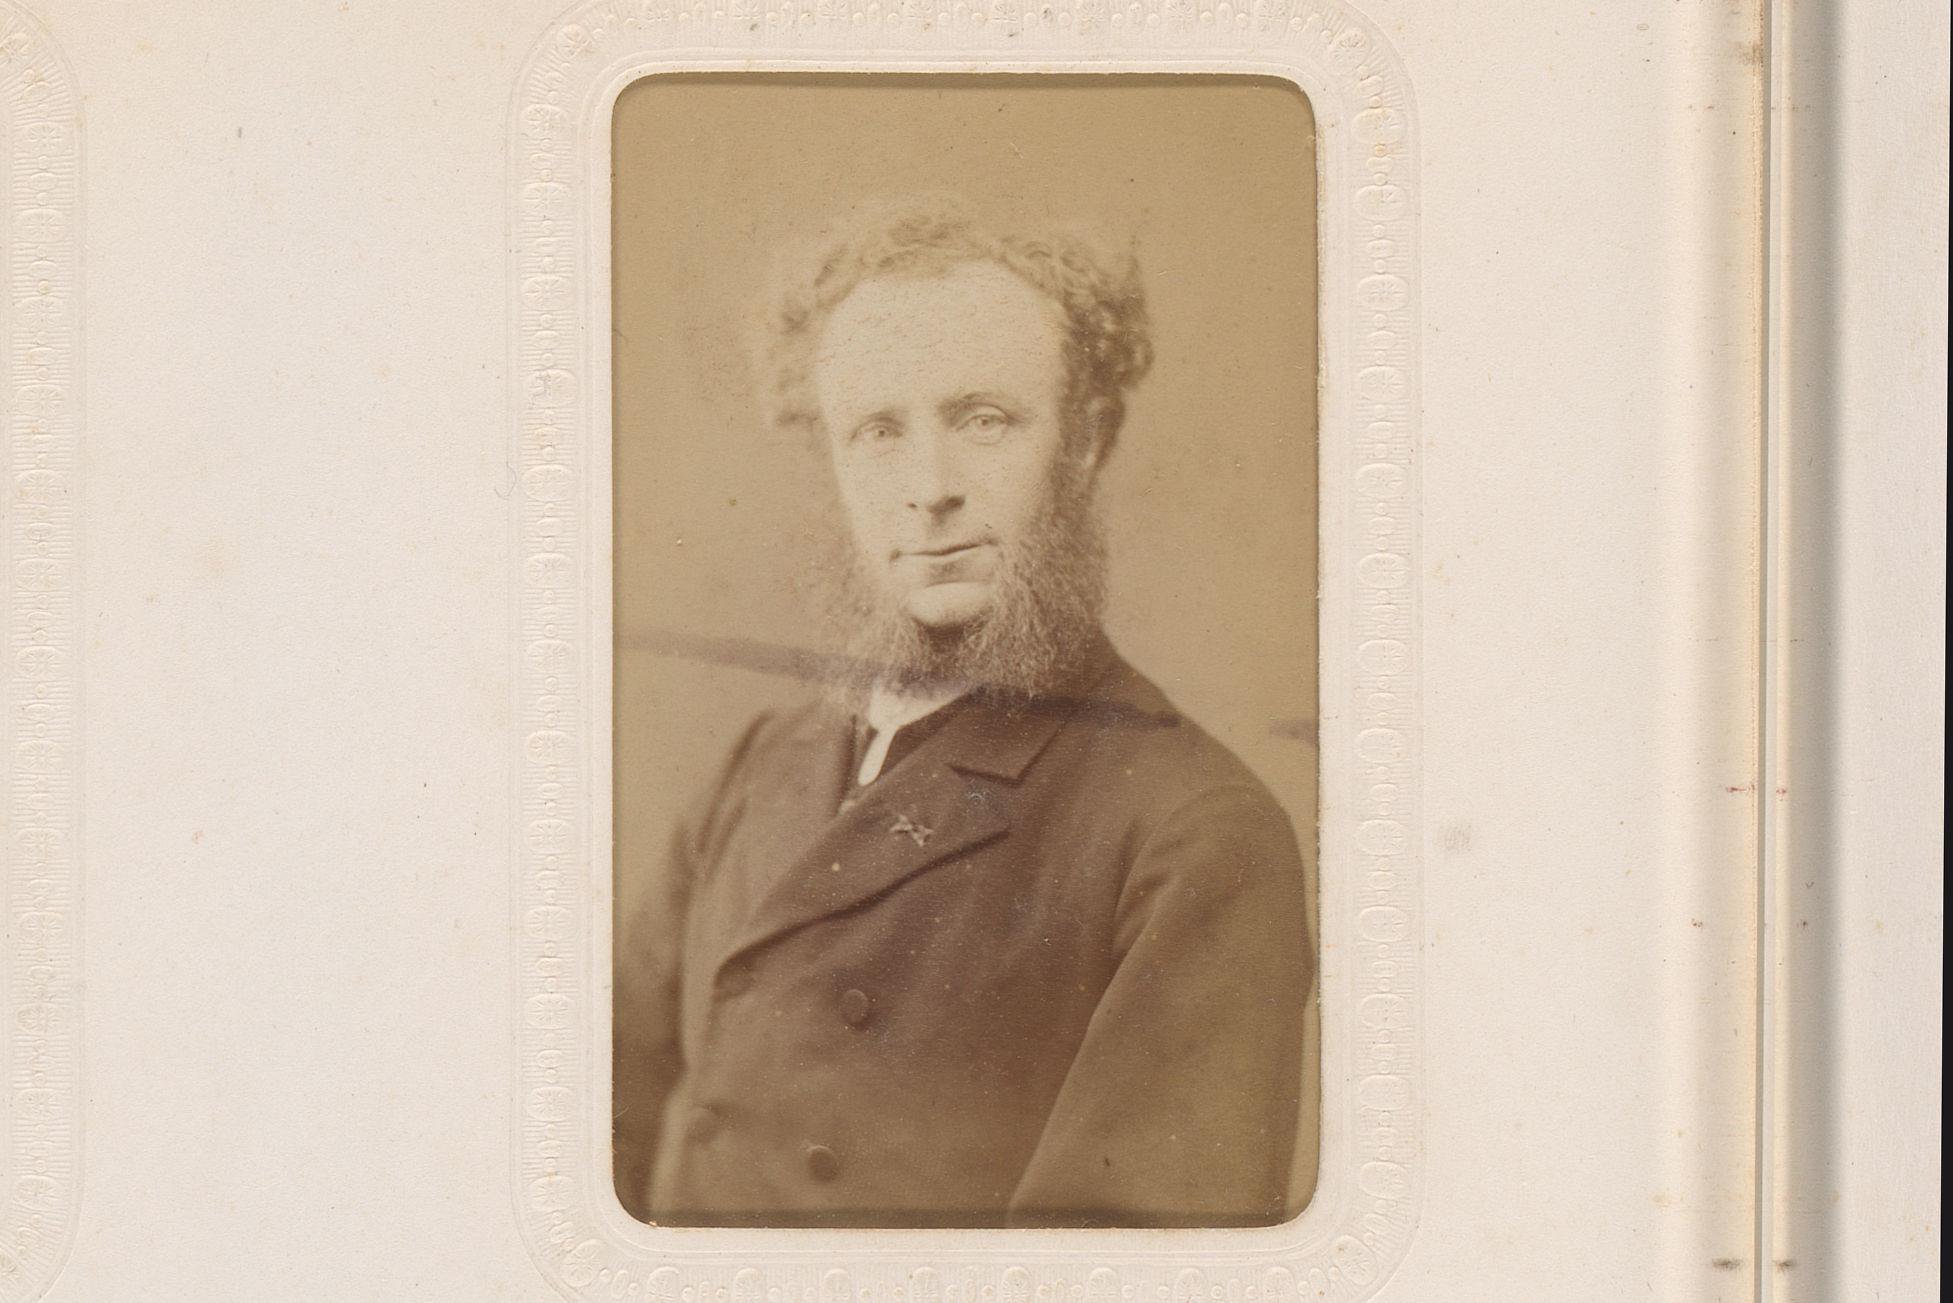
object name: photograph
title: Portret van een man met ringbaard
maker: Anonymous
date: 1860-1900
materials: cardboard, photographic support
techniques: albumen print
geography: amsterdam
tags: historical persons, beard